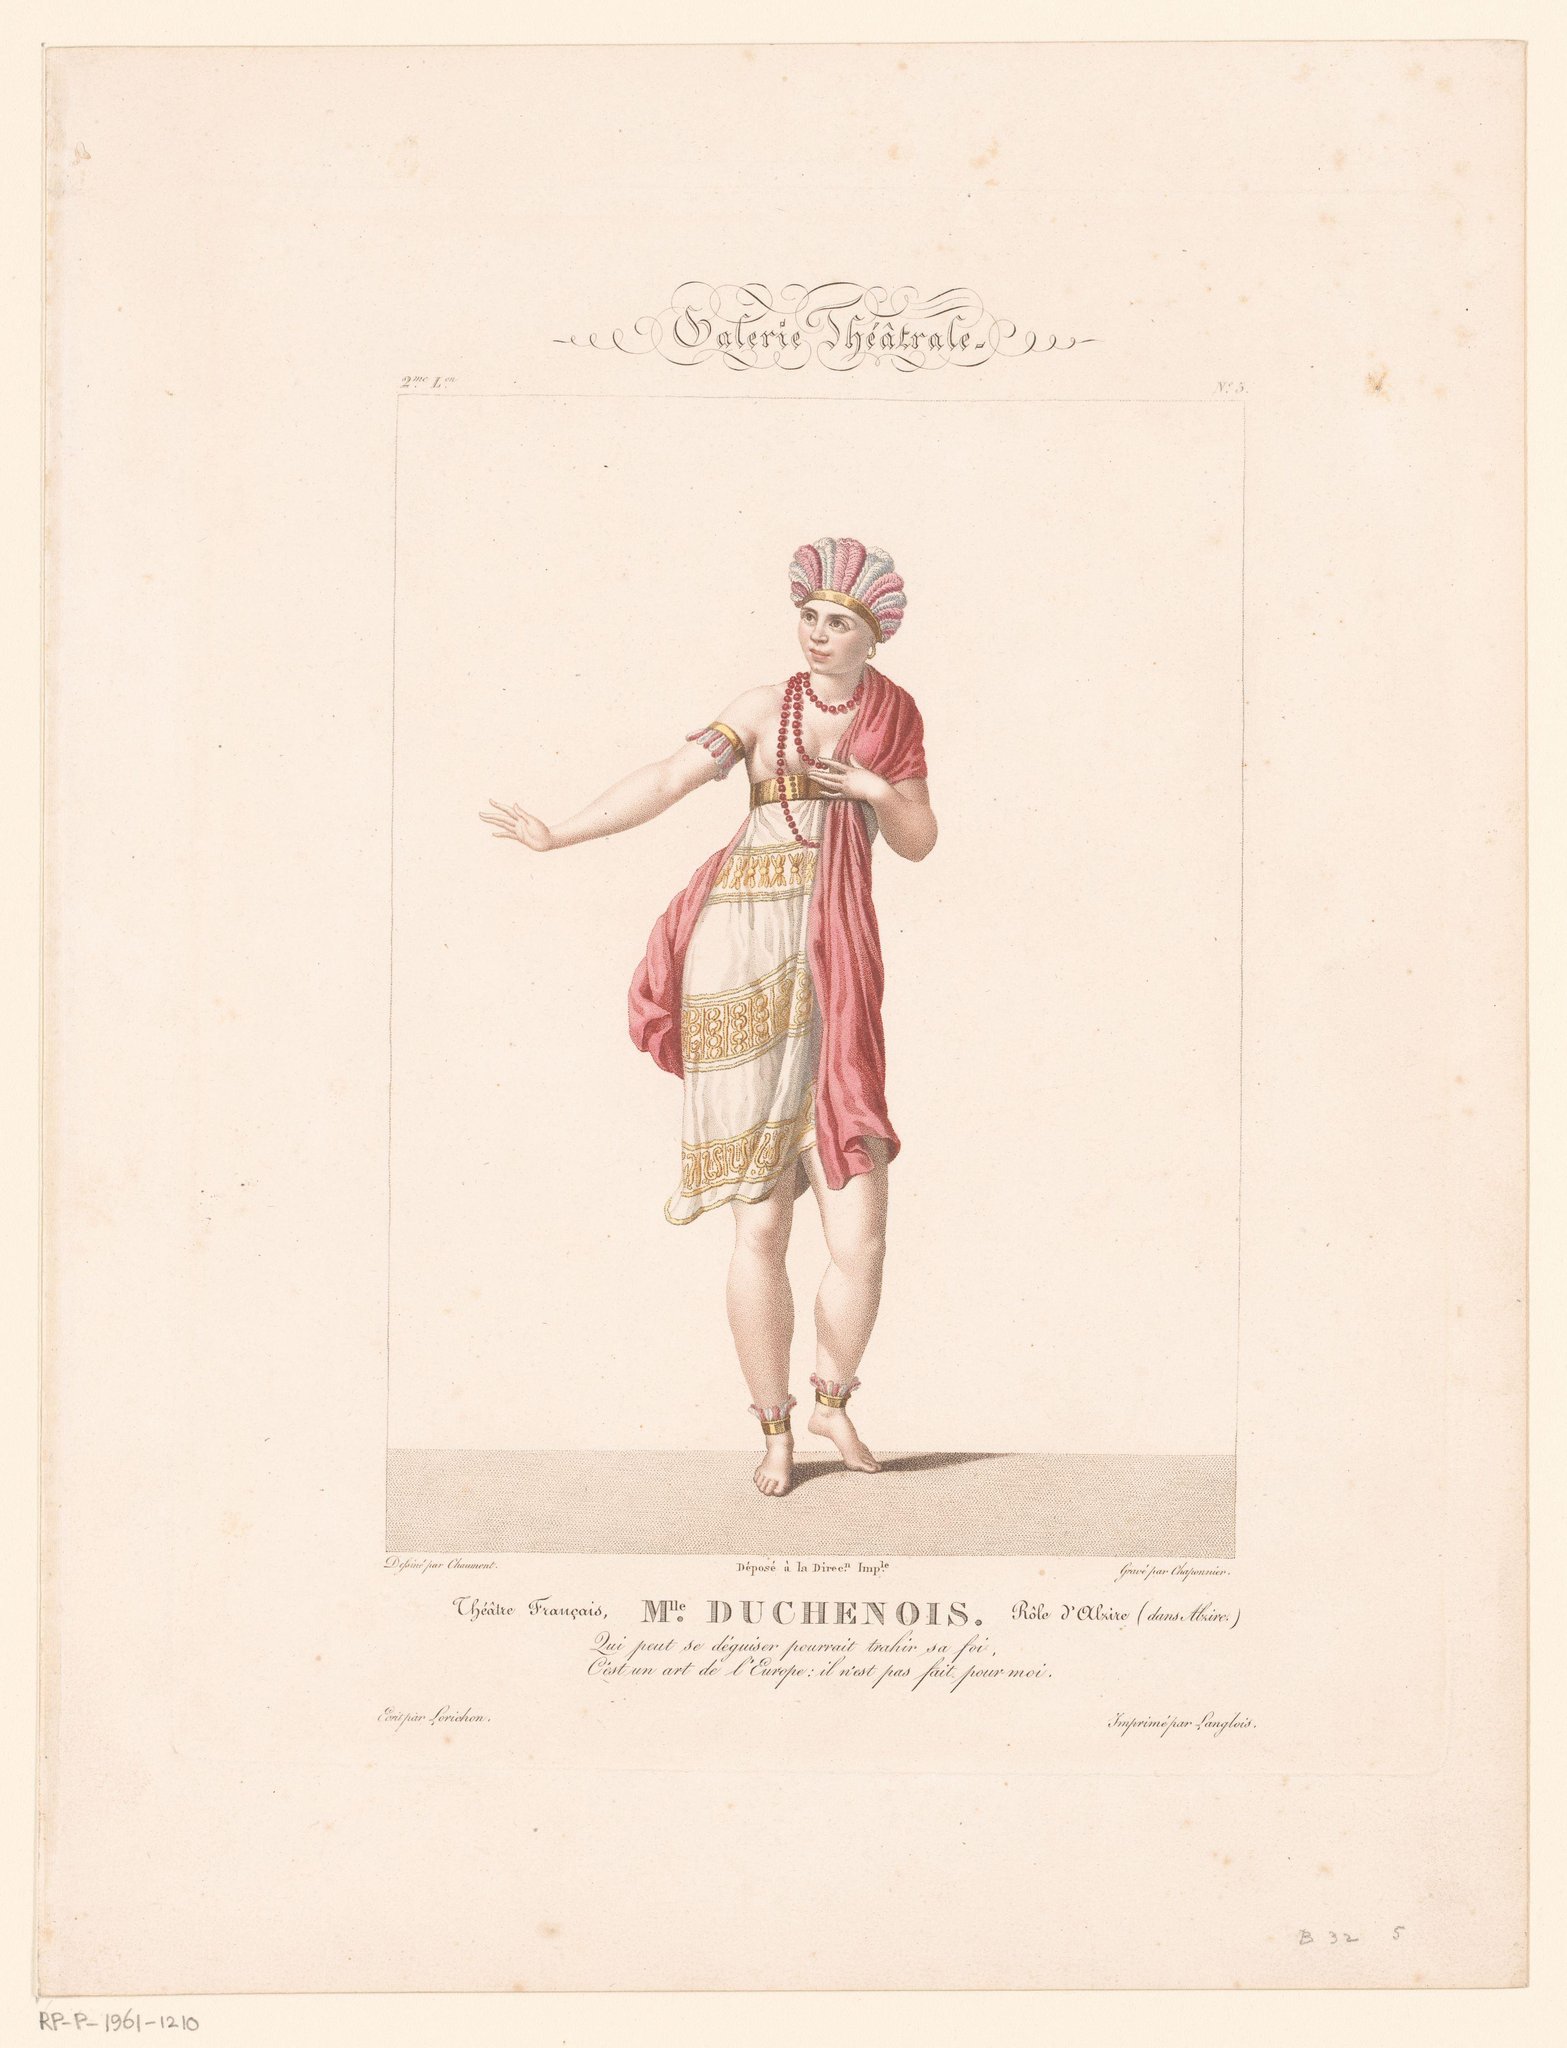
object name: book illustration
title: Portret van mevrouw Duchenois in de rol van Alzire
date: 1812-1834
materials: paper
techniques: printing, roulette, engraving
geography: france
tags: portrait of artiste (dancer, actor, etc.), historical persons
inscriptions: collector's mark: Lugt 2228, collector's mark: ‘cirkel met daar omheen de tekst: school voor de grafische vakken te Utrecht’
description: Prent uit: Galerie théâtrale ou collection des portraits en pied des principaux acteurs des premiers théâtres de la capitale. Parijs: Bance aîné, 1812-1834.